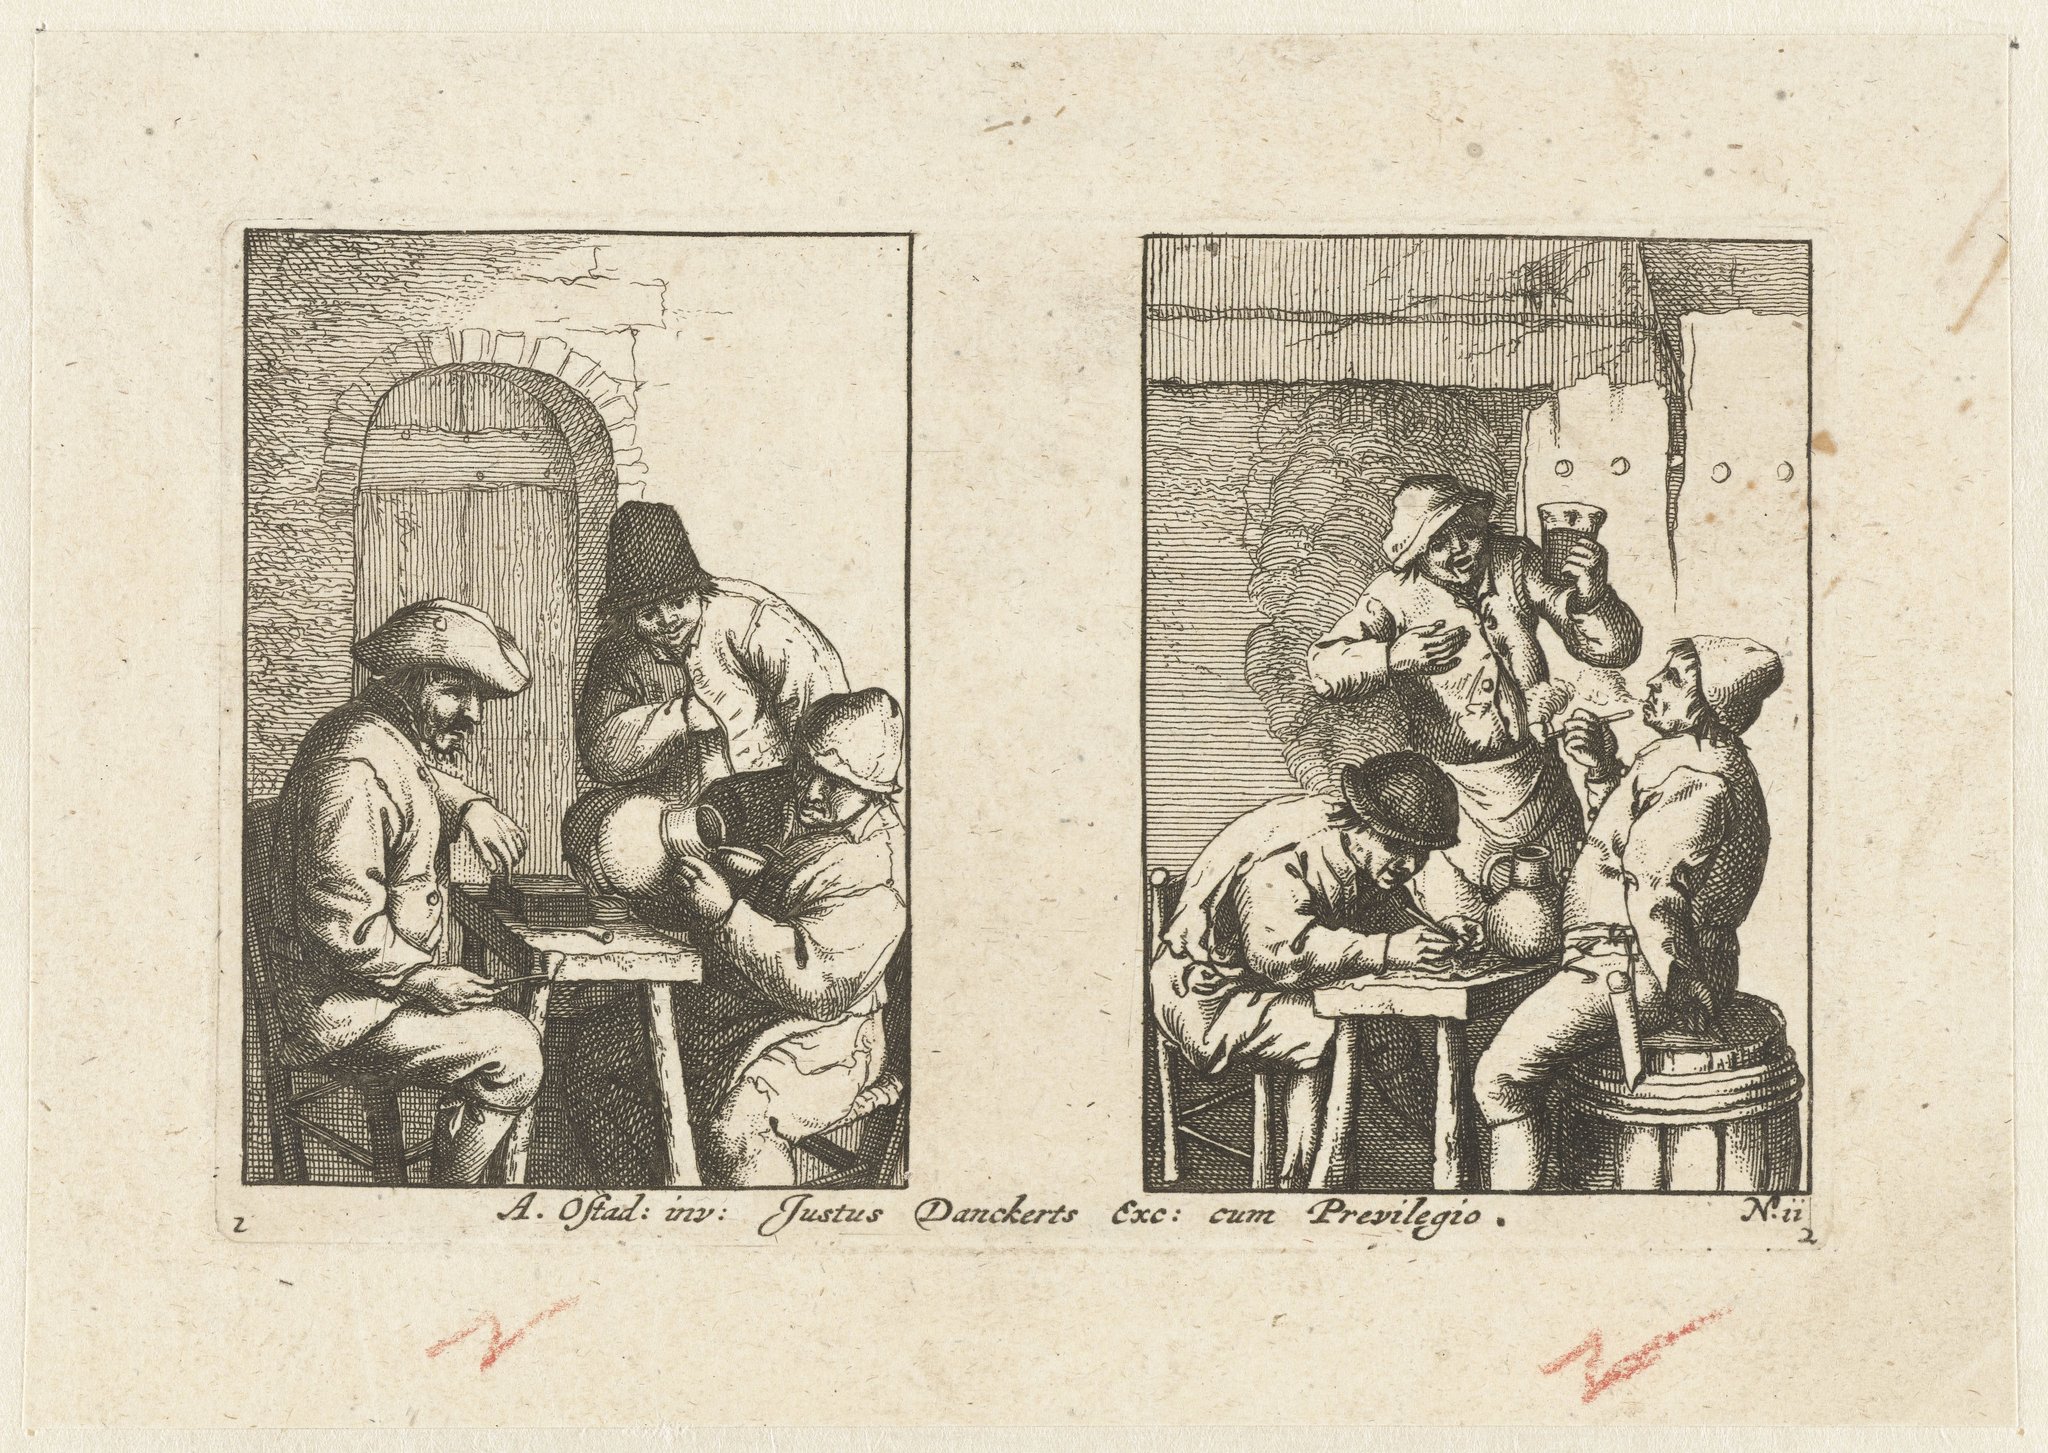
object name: print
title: Twee herbergscènes: De lege kruik en De twee rokers en de drinkende boer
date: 1651-1745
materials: paper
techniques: etching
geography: netherlands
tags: inn, coffee-house, public house, etc., pipe ~ tobacco, drinking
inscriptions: collector's mark: Lugt 2228a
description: Twee herbergscènes: man kijkt in lege kruik, twee mannen kijken toe en twee rokers en drinker in herberg. Twee kopieën naar prenten van Adriaen van Ostade zijn samengevoegd op een etsplaat